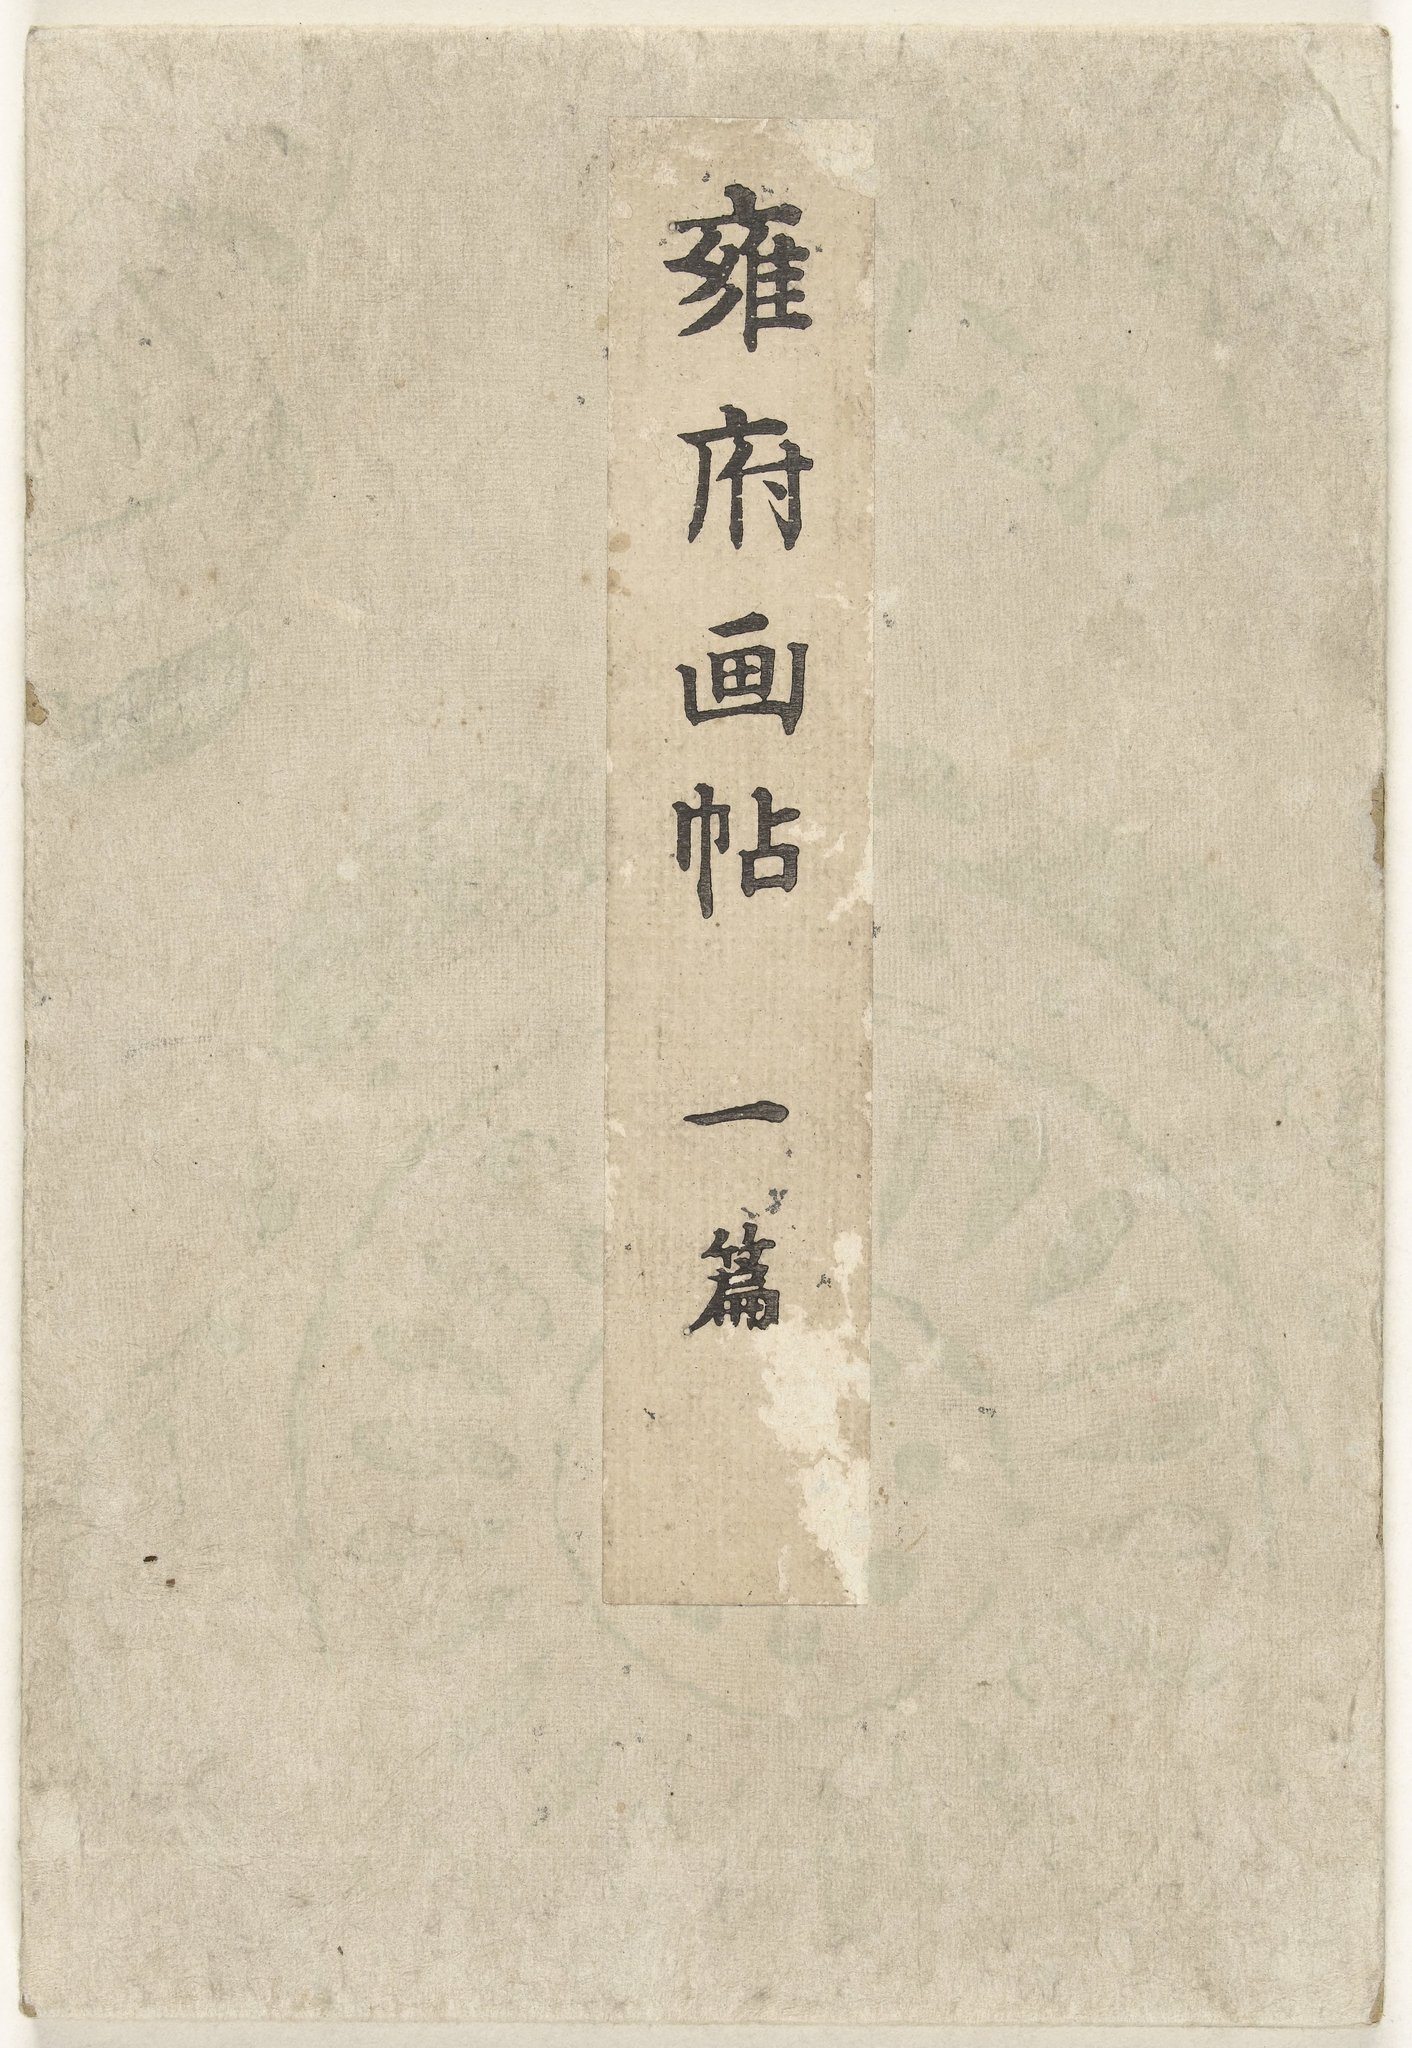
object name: book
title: Yofu gacho - ichihen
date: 1895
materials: paper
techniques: woodcut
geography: japan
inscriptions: collector's mark: Lugt 2228